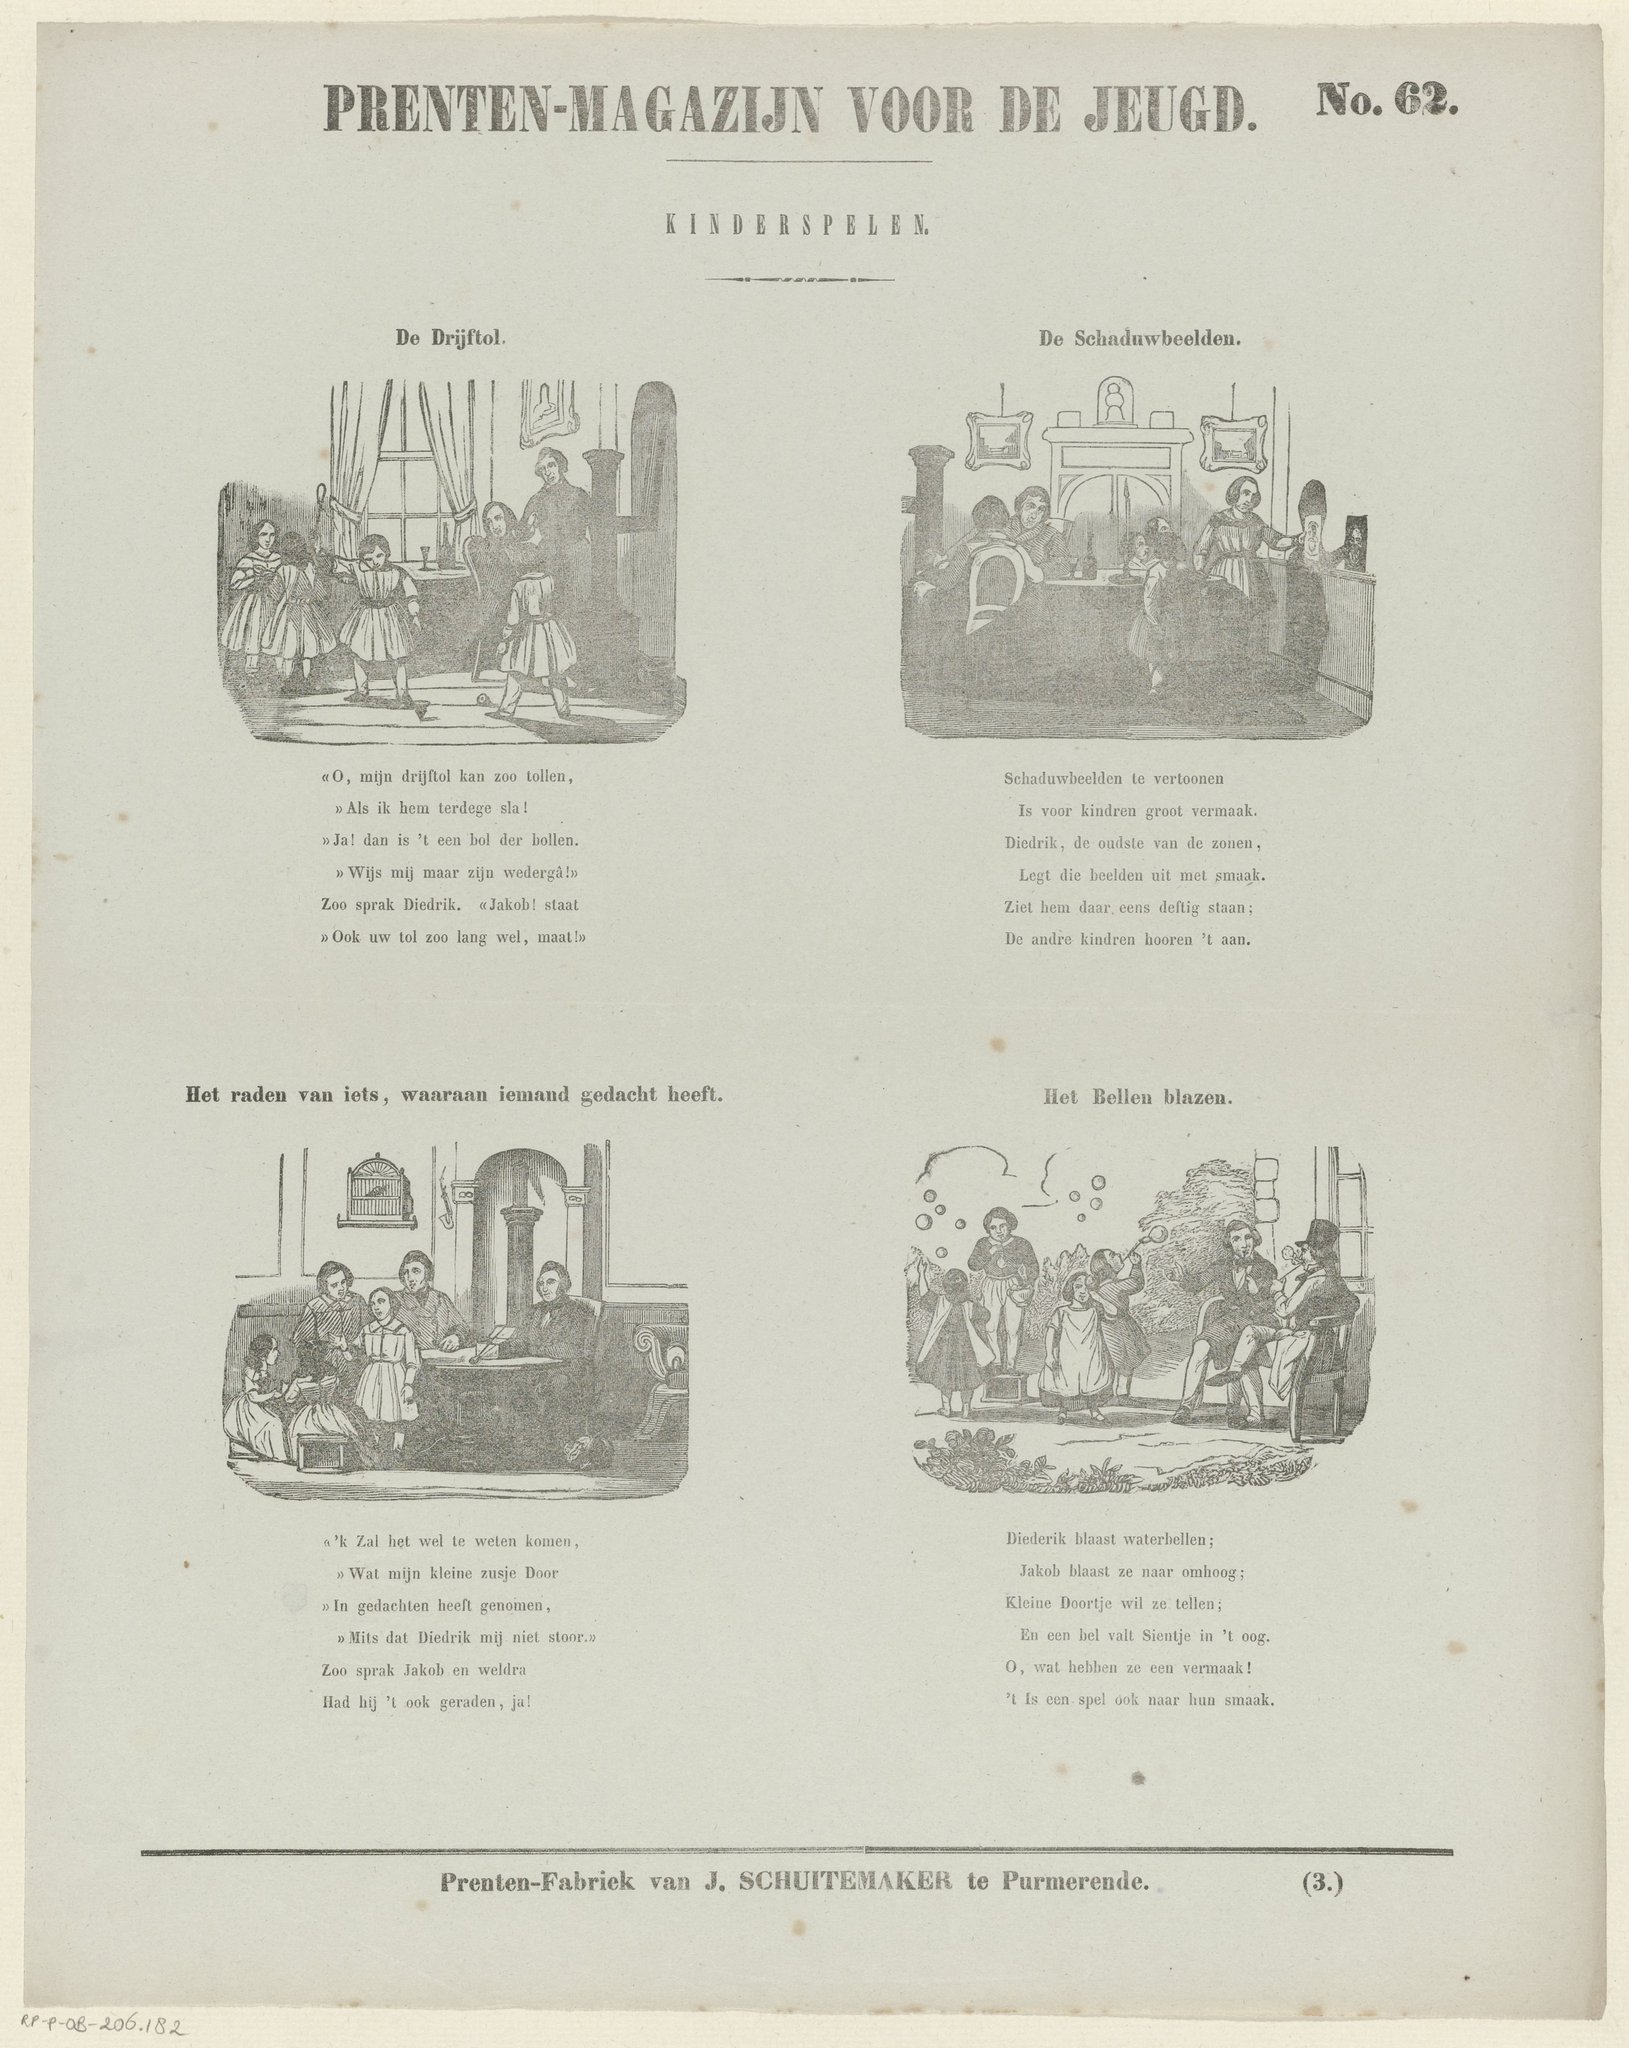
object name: popular print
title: Prenten-magazijn voor de jeugd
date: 1850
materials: paper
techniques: letterpress printing, engraving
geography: purmerend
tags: bubble-blowing (children's games and plays), children's games and plays, guessing games (children), shadow pictures (~ hand games), games using special objects (marbles, top, hoop, etc.)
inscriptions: collector's mark: Lugt 2760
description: Na voltooiing van de acht jaargangen van de reeks 'Prenten-magazijn voor de jeugd' in 1850 heeft Jan Schuitemaker al deze prenten heruitgegeven en omgenummerd als nr. 1 t/m 192. De oorspronkelijke jaargang wordt telkens nog vermeld rechtsonder op de prent. Binnen de jaargangen zijn prenten van hetzelfde thema in clusters van vier achter elkaar gezet.